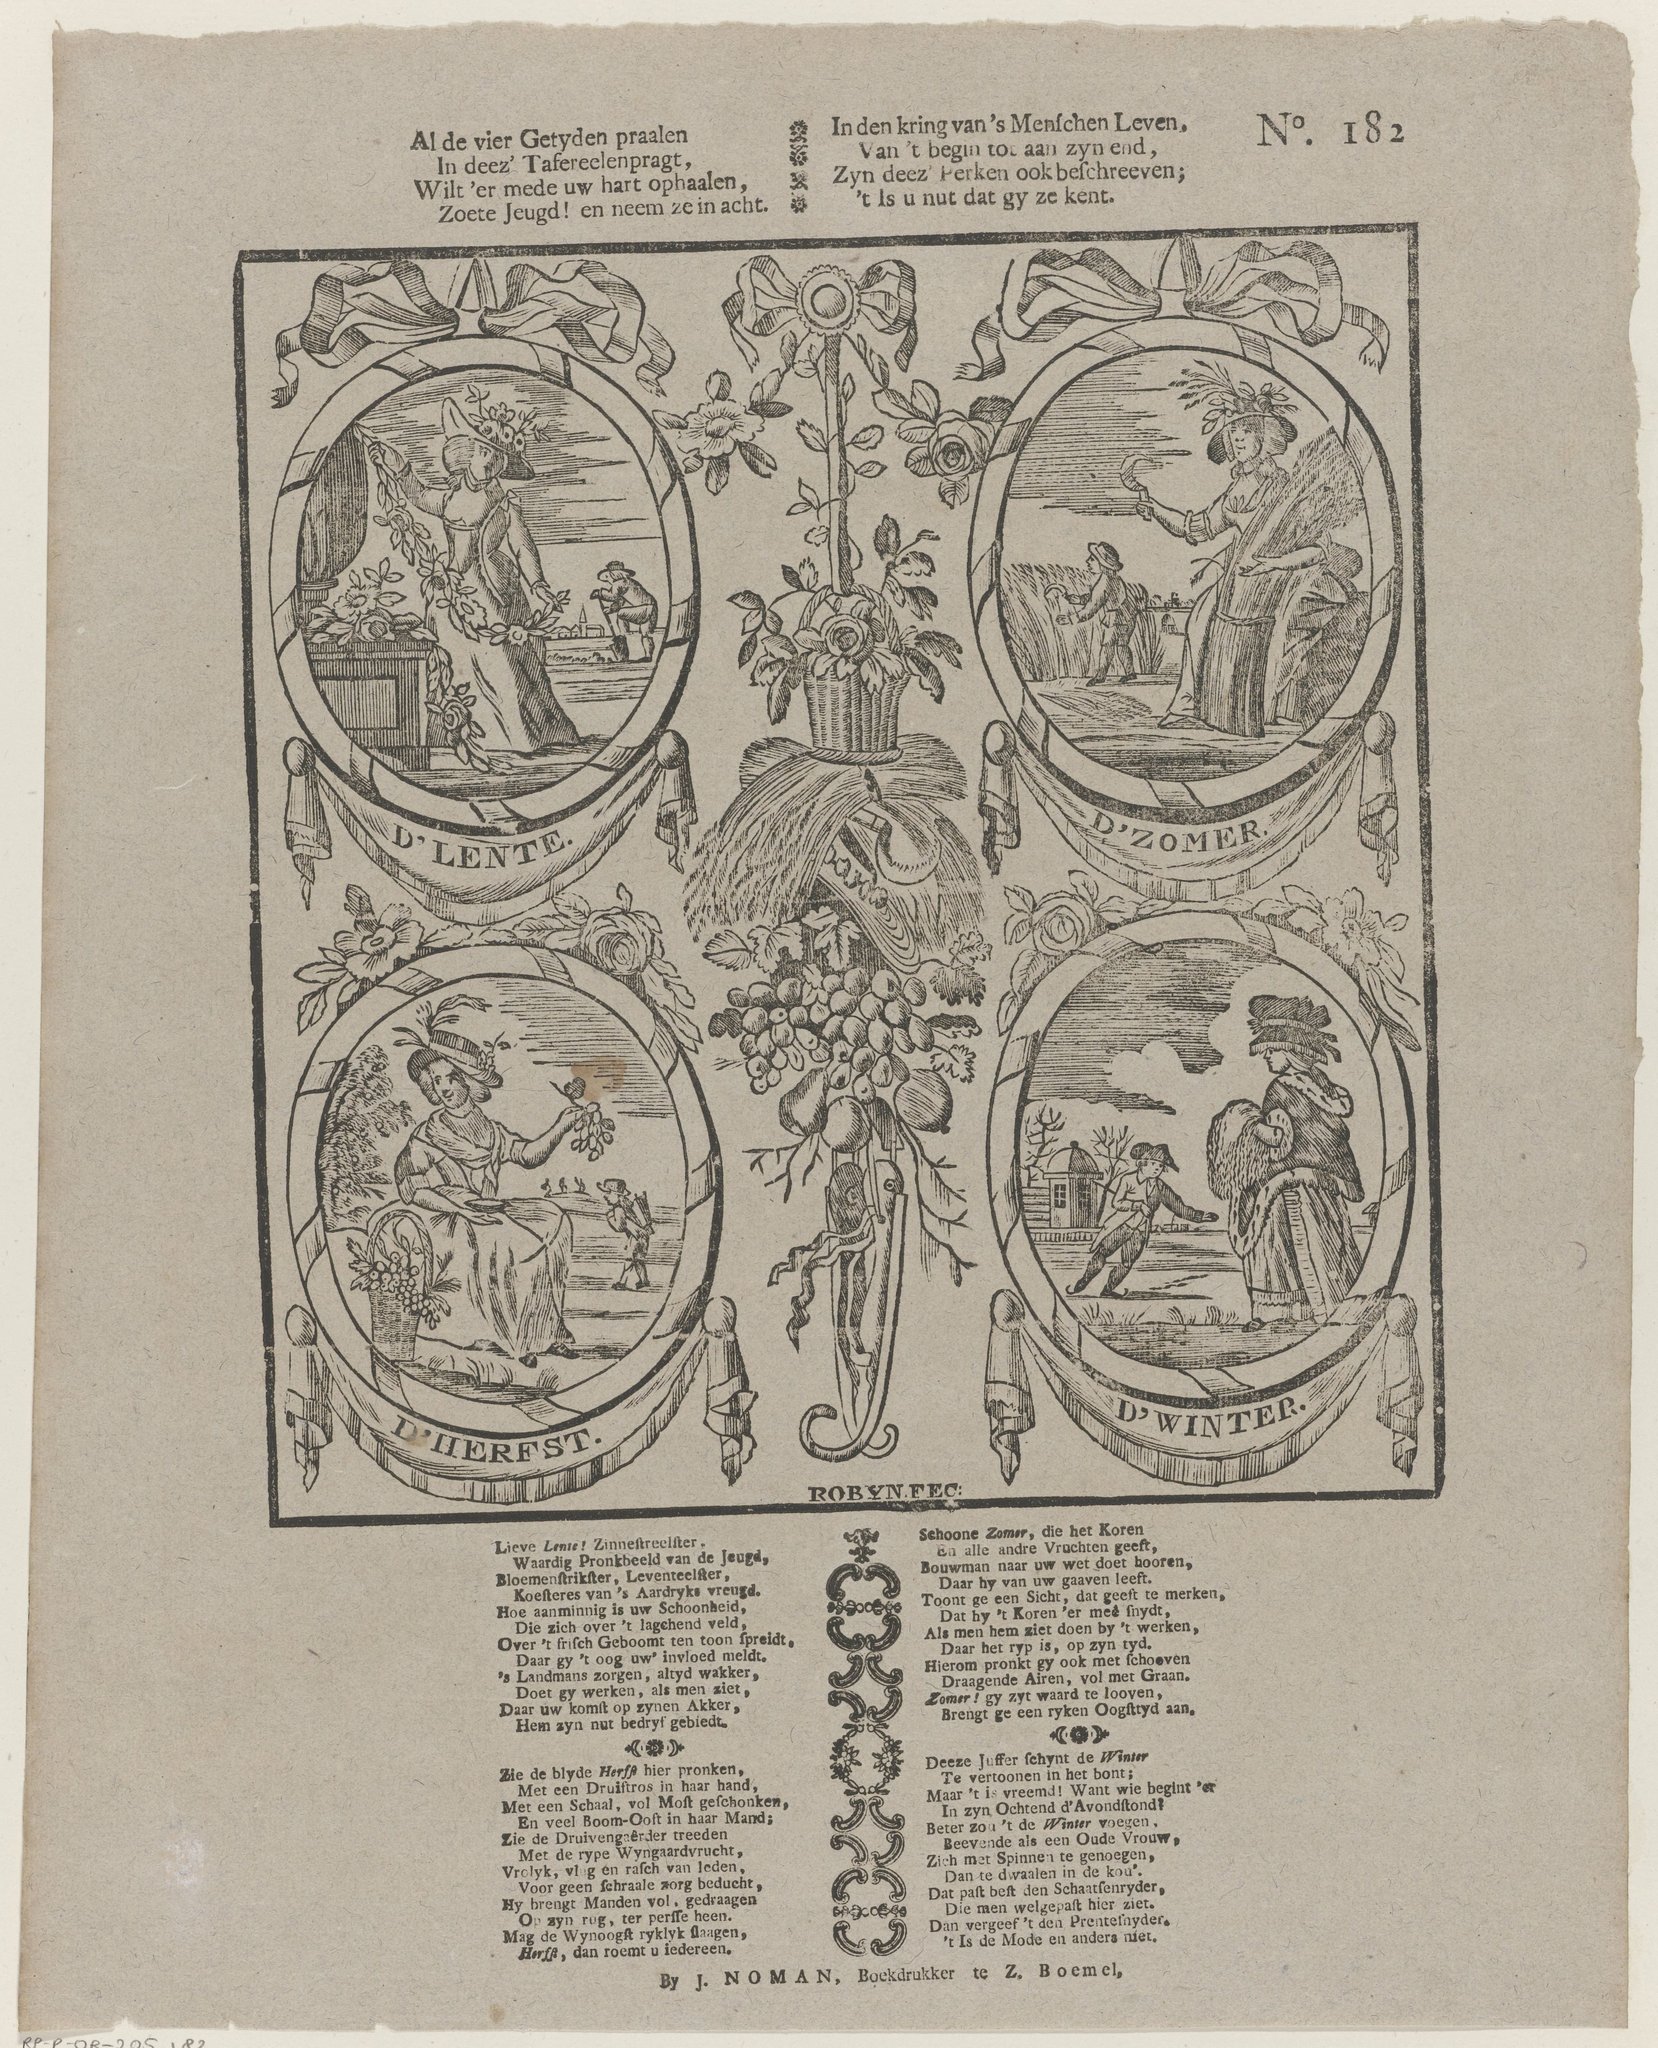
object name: popular print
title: Al de vier getyden pralen / In deez' tafreelenpragt [(...)]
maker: johan noman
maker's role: printer, publisher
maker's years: -1833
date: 1806-1830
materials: paper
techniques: letterpress printing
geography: zaltbommel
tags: the four seasons of the year ~ human activities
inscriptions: collector's mark: Lugt 2760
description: Vier medaillons met voorstellingen van de vier jaargetijden en bijbehorende activiteiten. Tussen de medaillons een trofee met producten uit de verschillende seizoenen. In de ondermarge een vers in twee kolommen. Genummerd rechtsboven: No. 182.